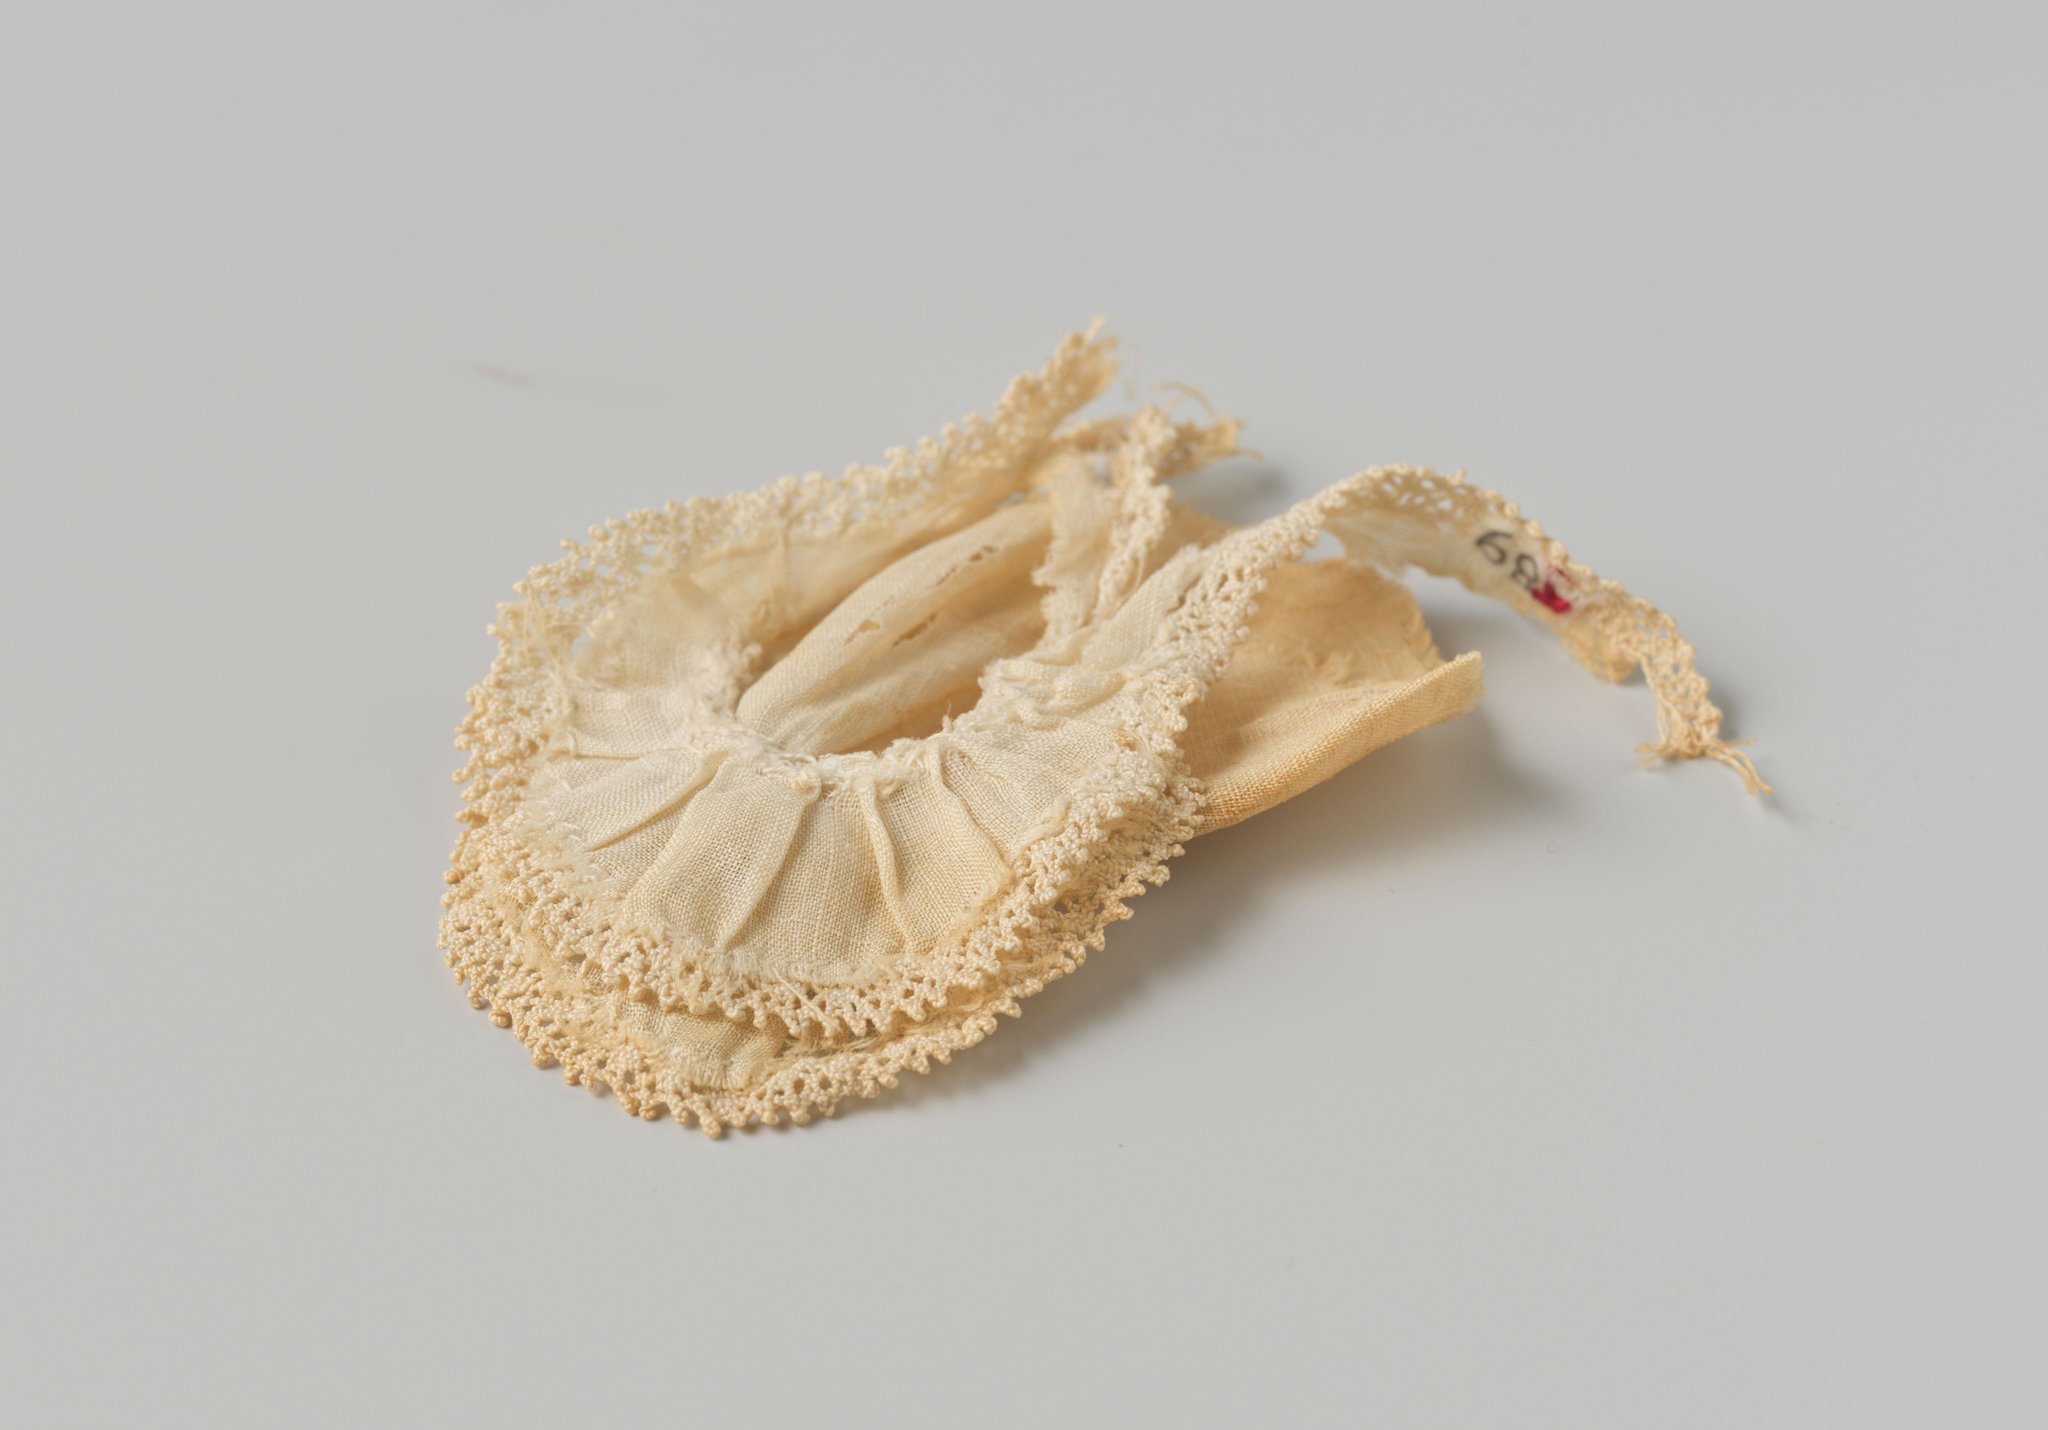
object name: miniature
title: Kraag, van wit linnen; bestaande uit een onafgewerkt schouderstuk, waar langs de halslijn een dubbele kraag met losse slippen is aangerimpeld, afgezet met linnen kloskant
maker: Anonymous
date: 1690-1710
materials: linen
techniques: lace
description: Kraag van wit linnen; bestaande uit een onafgewerkt en ongezoomd schouderstuk, waar langs de halslijn een dubbele kraag met losse slippen is aangerimpeld. De kraag is afgezet met linnen kloskant.